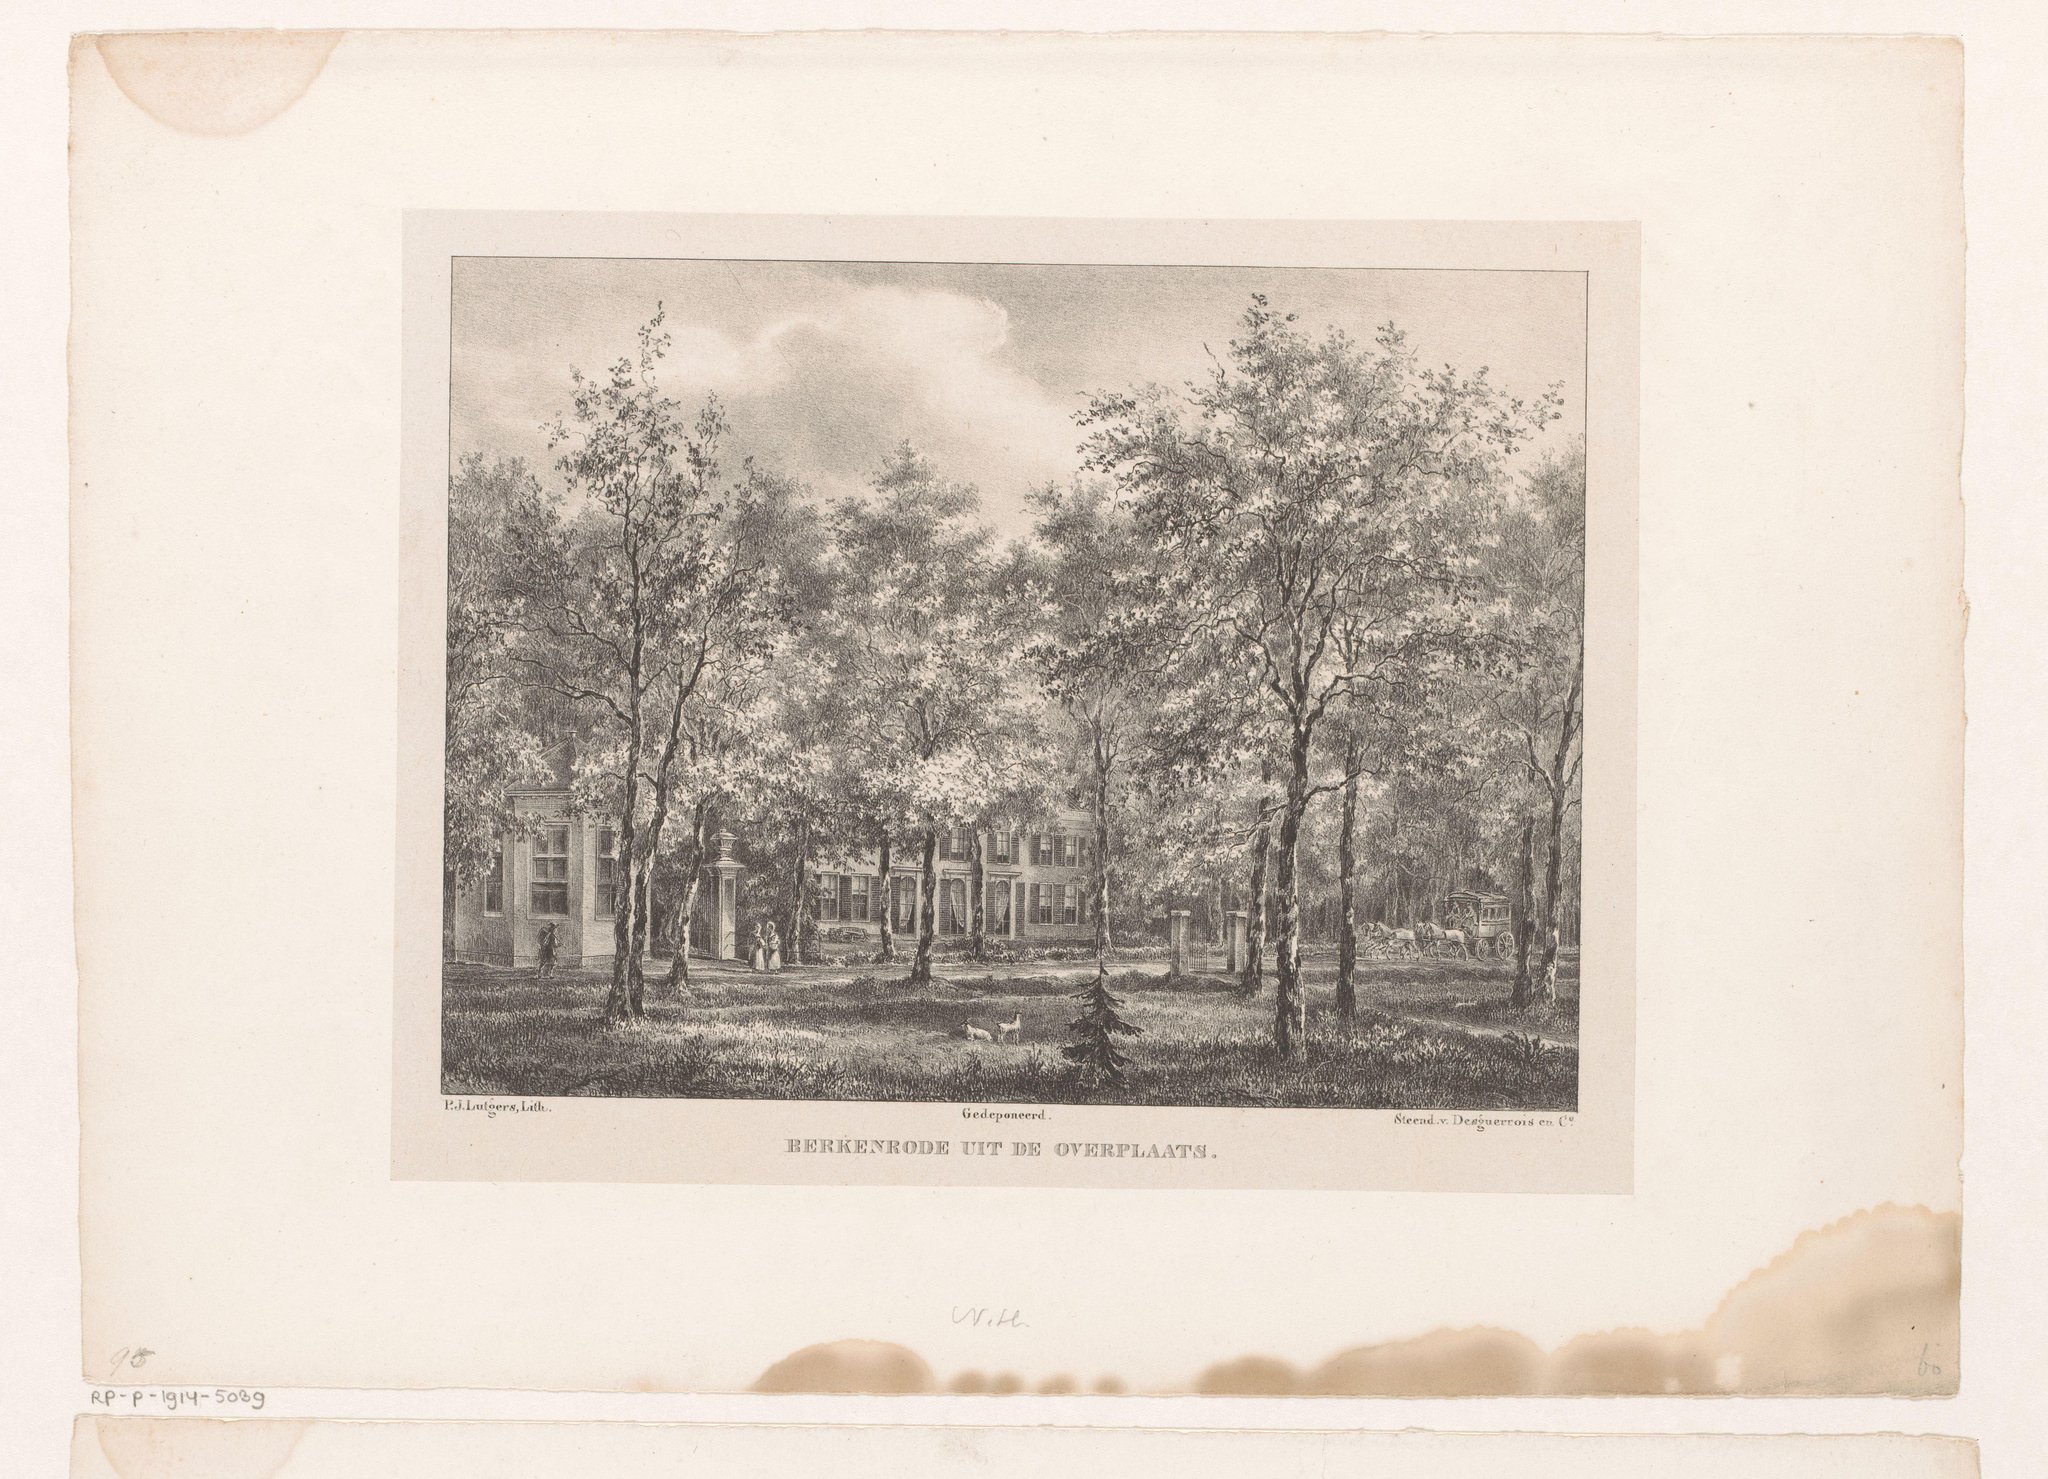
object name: print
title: Gezicht op huis Berkenrode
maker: petrus josephus lutgers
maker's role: draughtsman, print maker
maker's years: 1808-1874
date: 1837-1844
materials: paper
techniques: lithograph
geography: amsterdam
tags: four-wheeled vehicle drawn by more than three animals, country-house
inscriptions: : ‘Gedeponeerd.’, collector's mark: Lugt 2228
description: Op de weg komt een rijtuig met vier paarden aangereden.